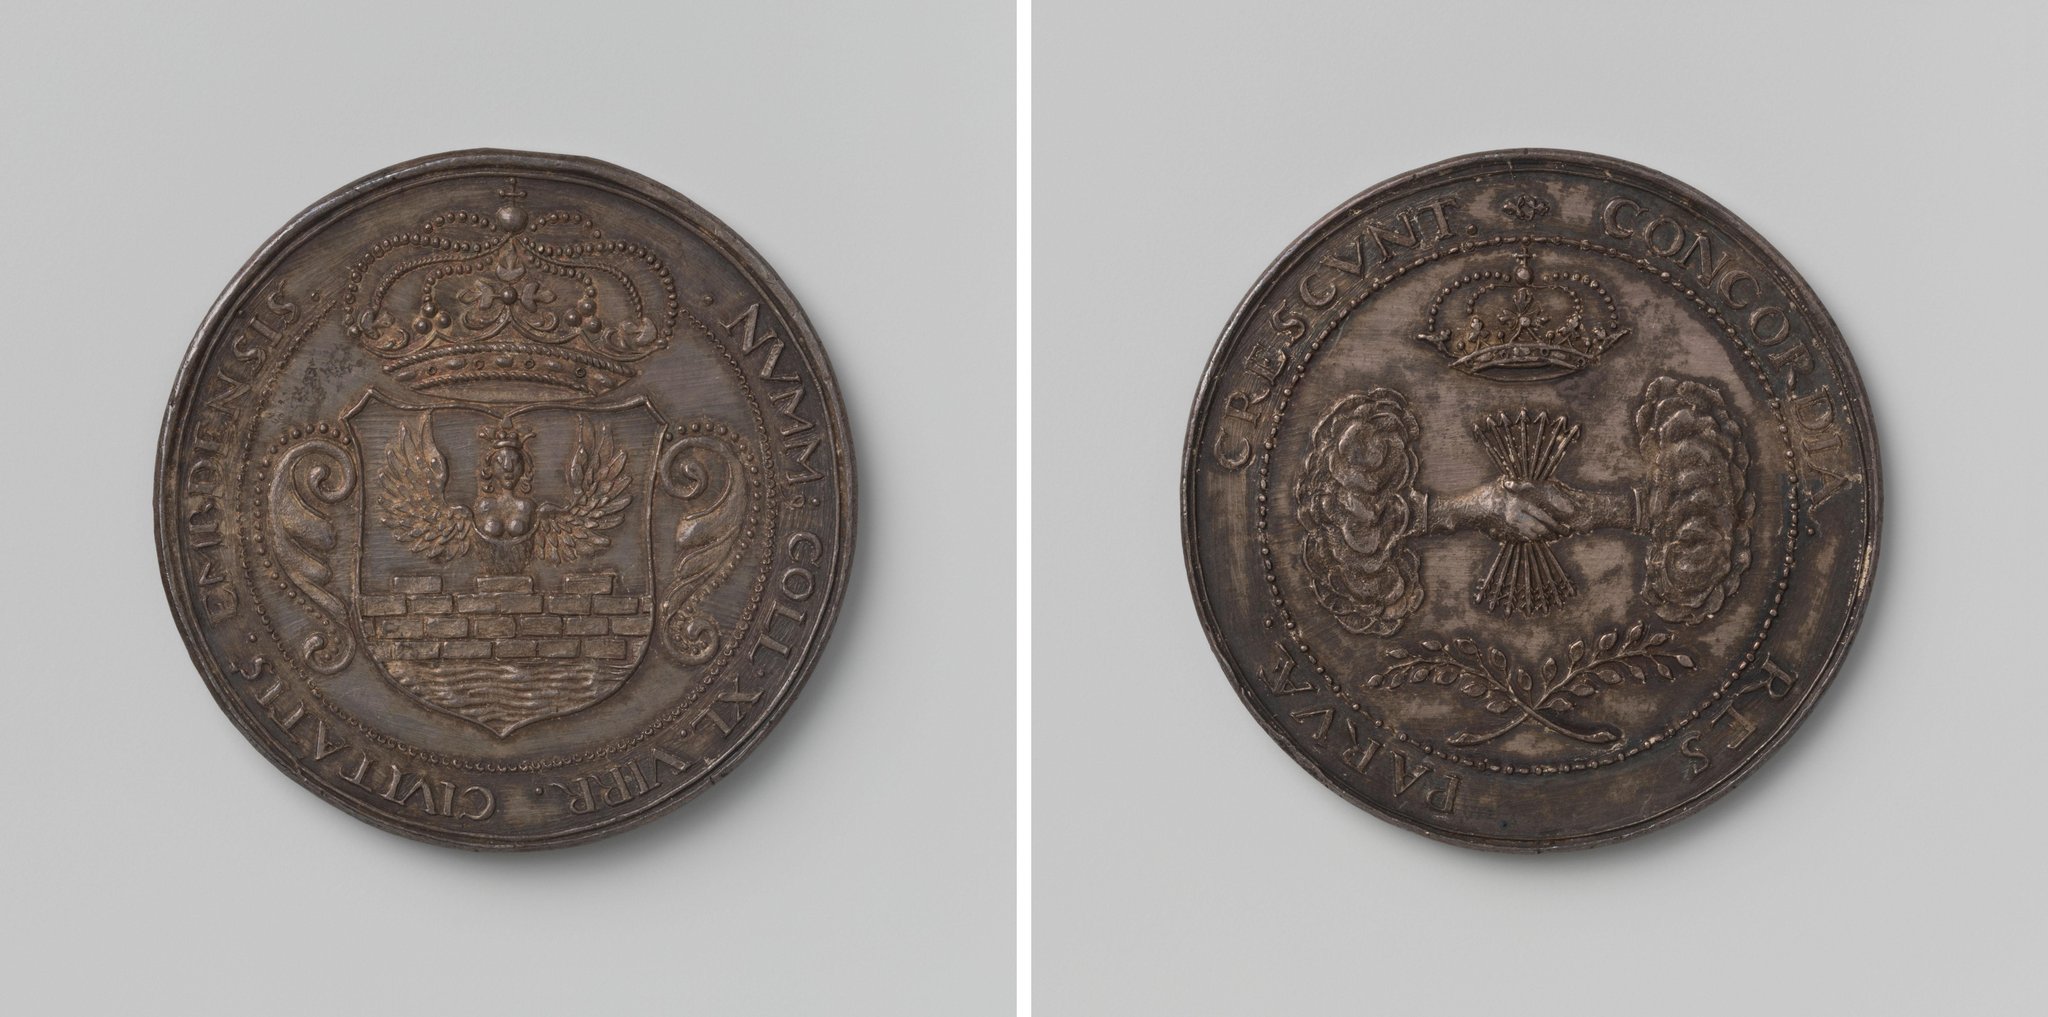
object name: council medal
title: Vroedschapspenning van de stad Embden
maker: Anonymous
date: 1650-1750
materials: silver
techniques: striking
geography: emden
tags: emden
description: Zilveren penning. Voorzijde: gekroond wapenschild in cartouche binnen omschrift. Keerzijde: twee ineen geslagen handen uit wolken houden samen bundel van zeven pijlen op vast onder kroon boven twee gekruiste bladertakken binnen omschrift